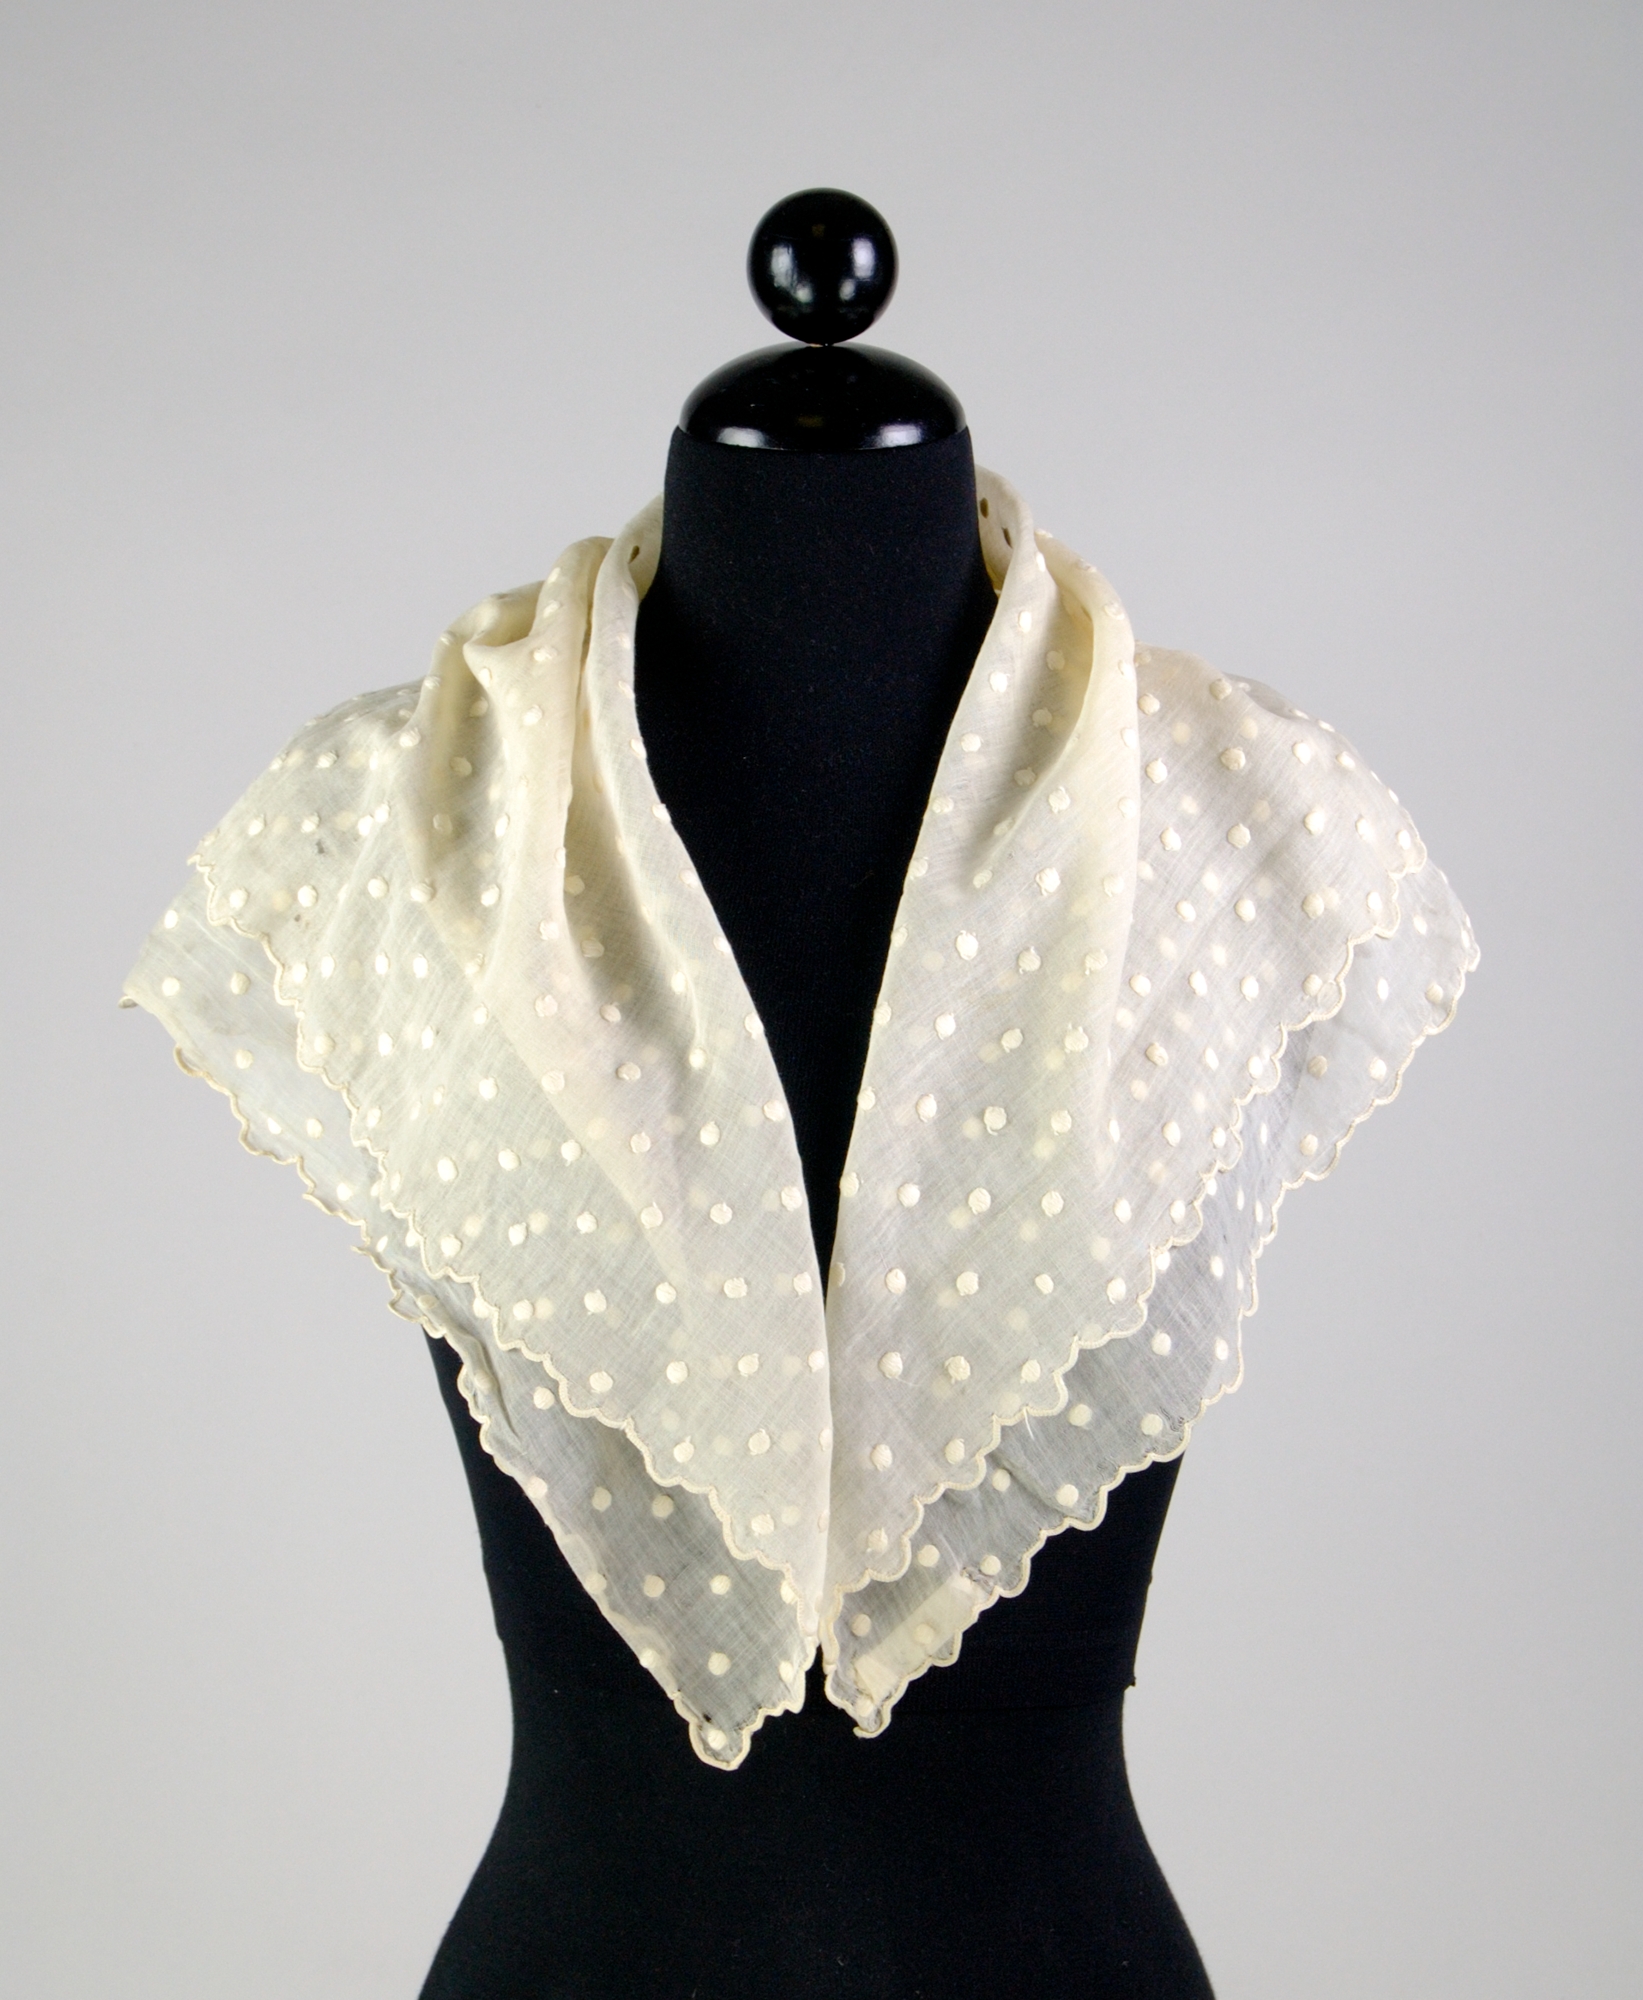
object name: fichu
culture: american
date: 1820-1840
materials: cotton